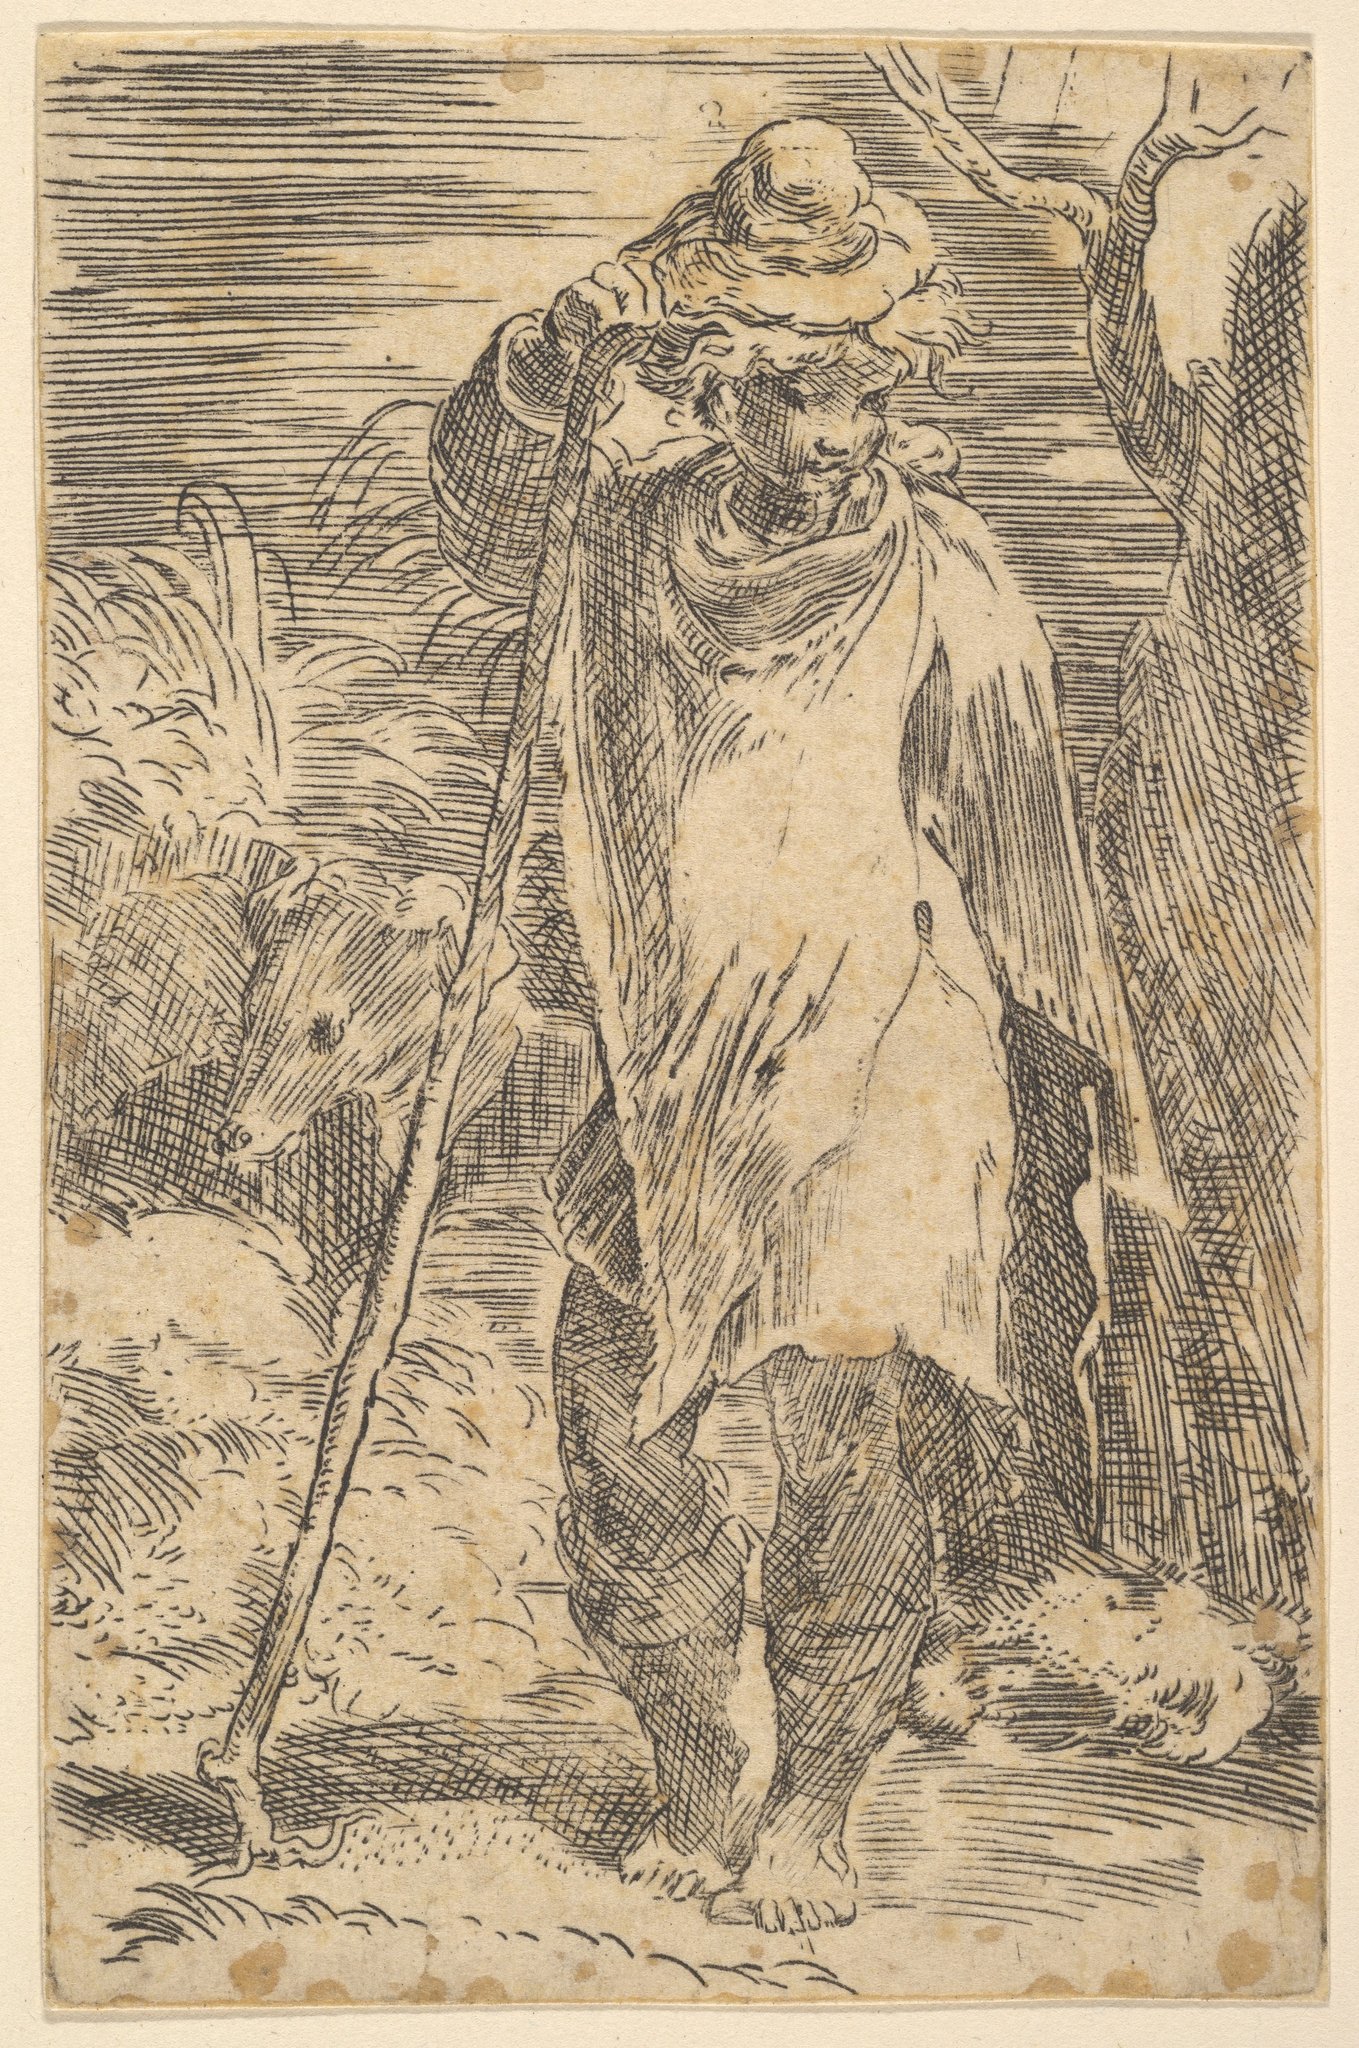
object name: print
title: Standing Shepherd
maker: parmigianino (girolamo francesco maria mazzola)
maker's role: artist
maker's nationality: italian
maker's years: 1503-1540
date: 1501-1533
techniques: etching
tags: human figures,animals,shepherds